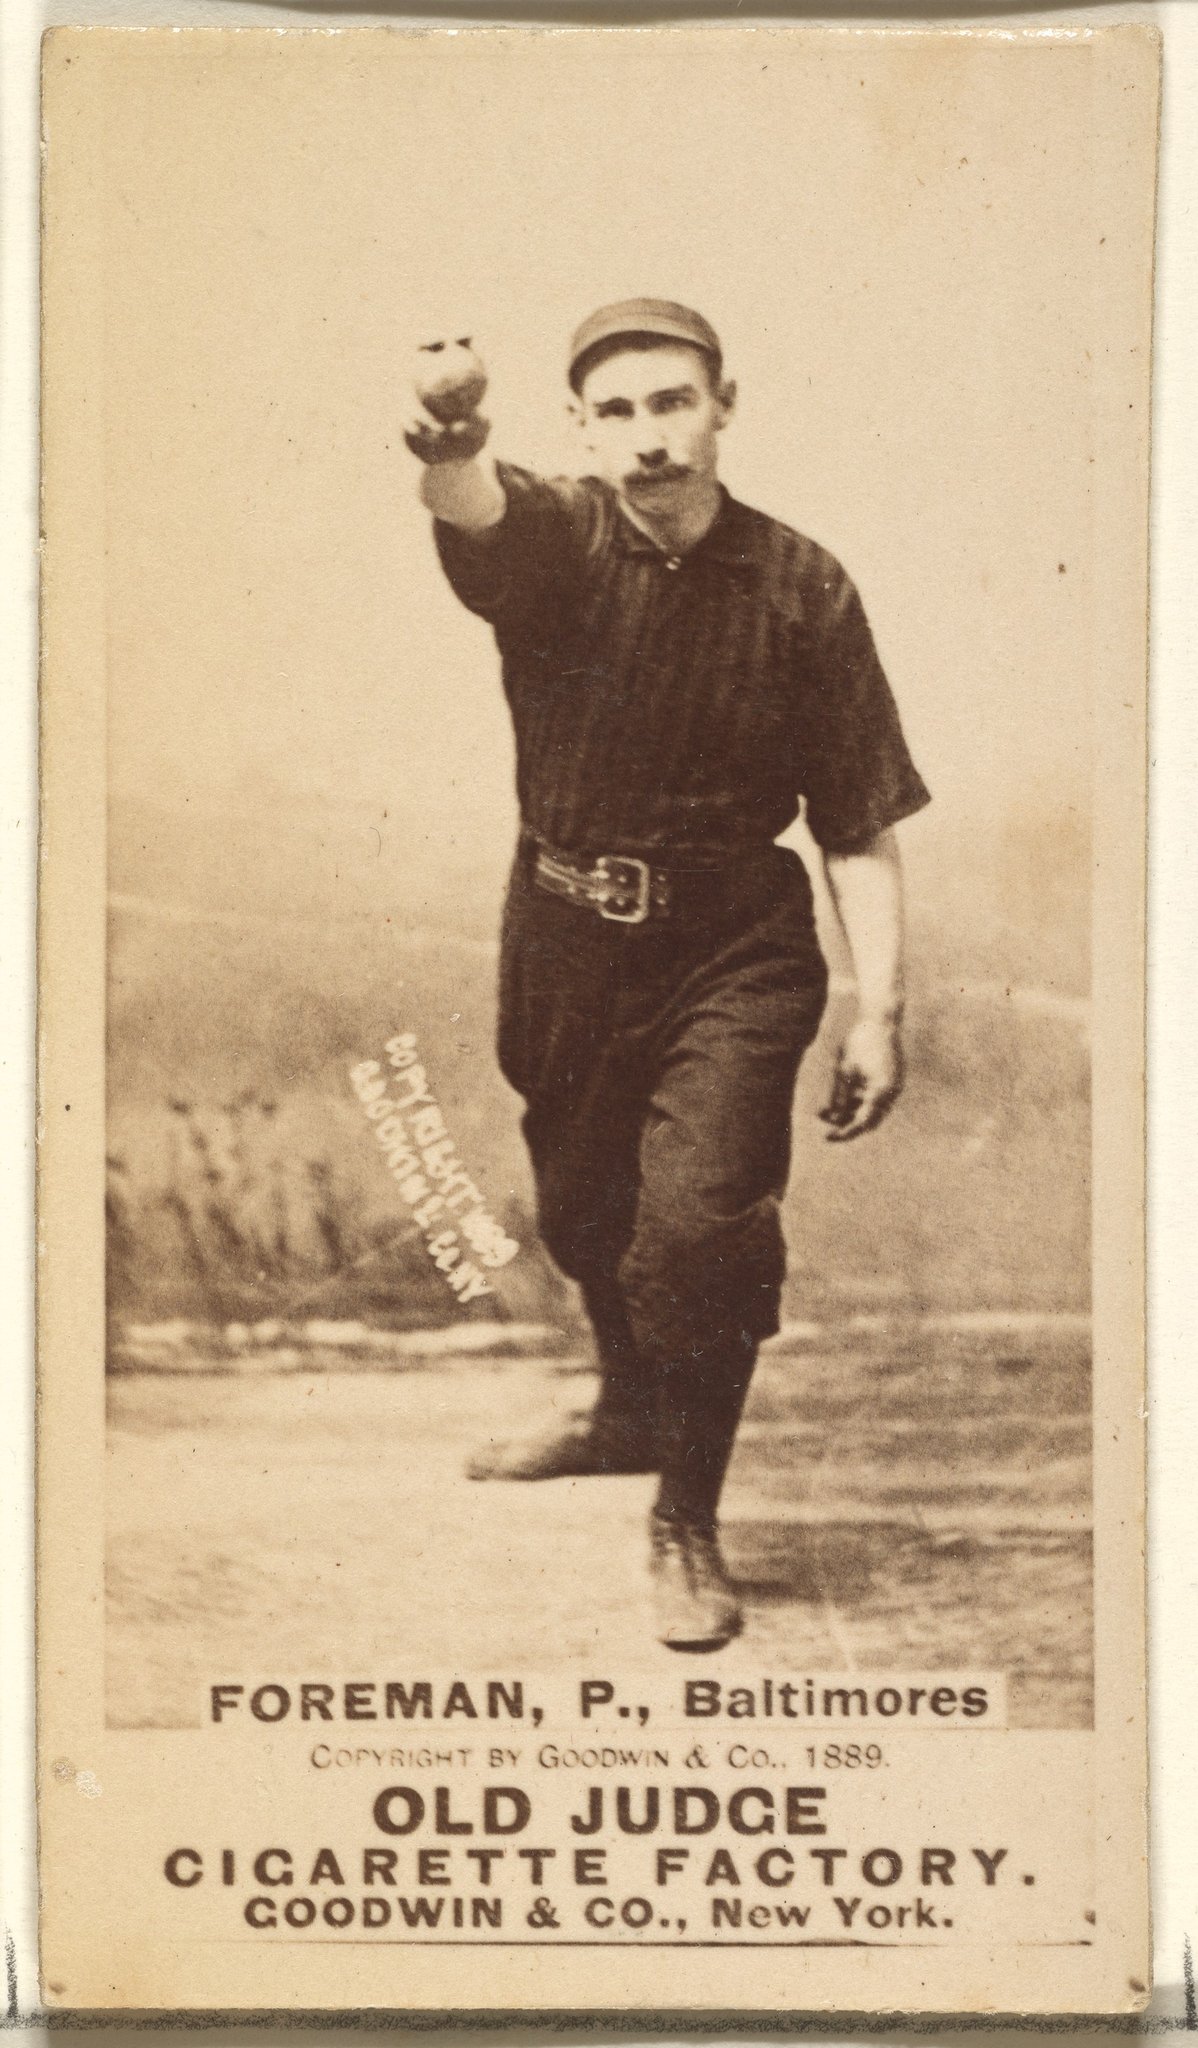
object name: baseball card, photograph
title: Foreman, Pitcher, Baltimore Orioles, from the Old Judge series (N172) for Old Judge Cigarettes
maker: goodwin & company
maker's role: publisher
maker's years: 1850-1950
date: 1889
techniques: albumen silver print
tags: men,portraits,baseball,athletes